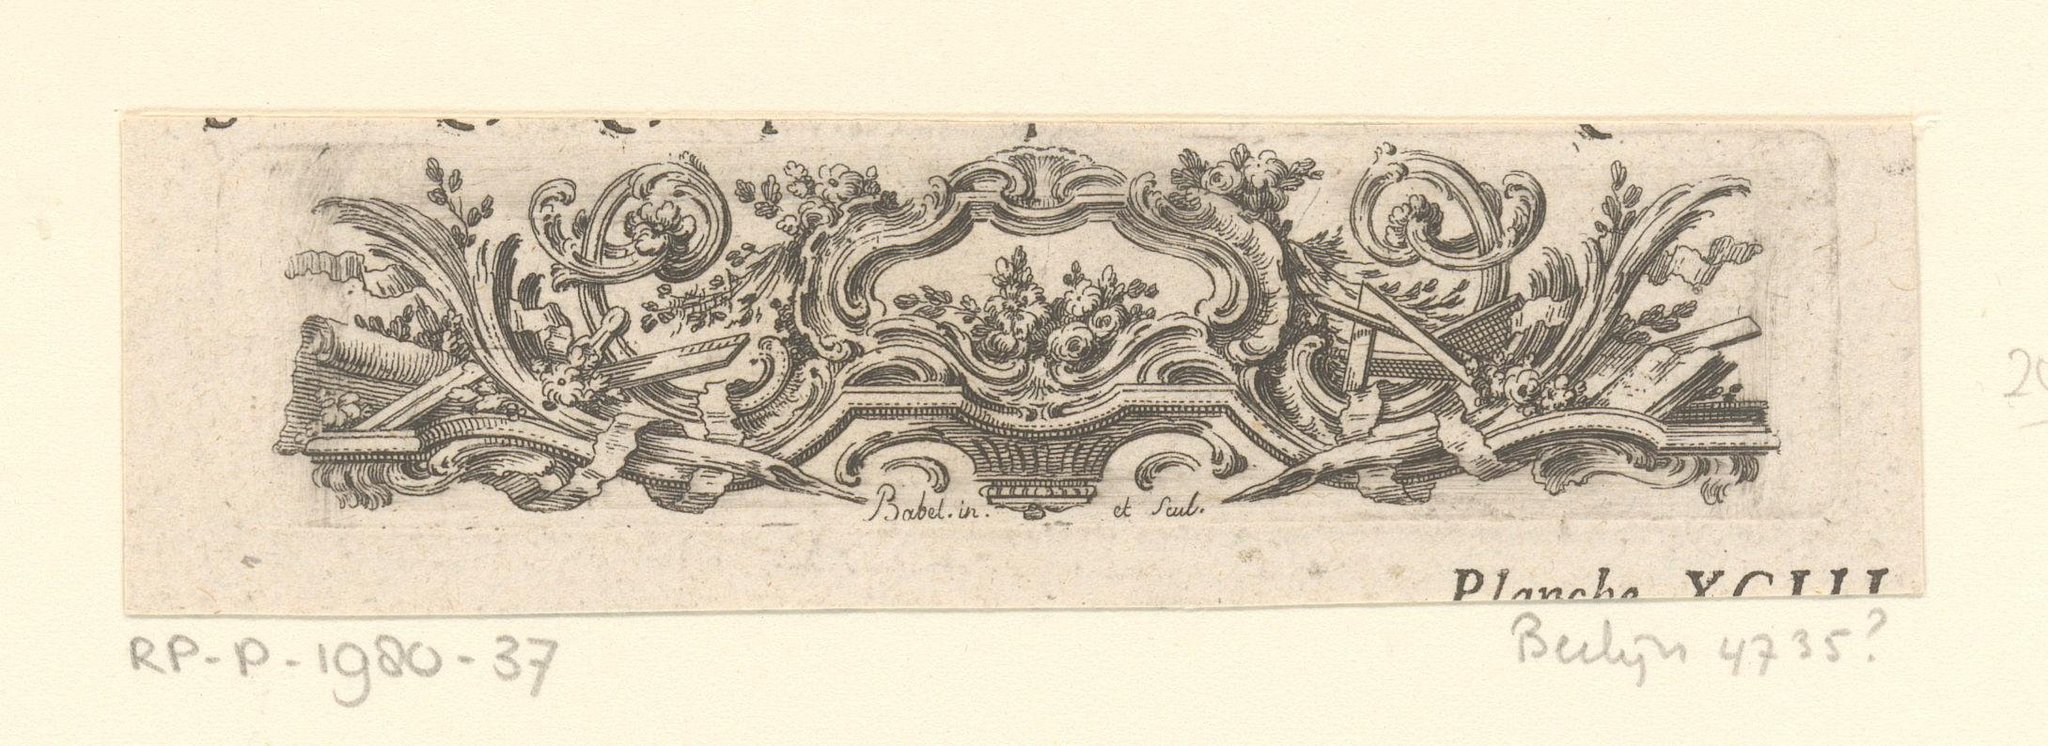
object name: ornament print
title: Vignet met meetkundige objecten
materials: paper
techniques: etching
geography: paris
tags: measuring-instruments, ornament ~ cartouche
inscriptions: collector's mark: Lugt 2228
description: Pagina 208 uit: Edme-Sébastien. Traité de perspective à l'usage des artistes (...). Parijs: Jombert, Charles Antoine, 1750.